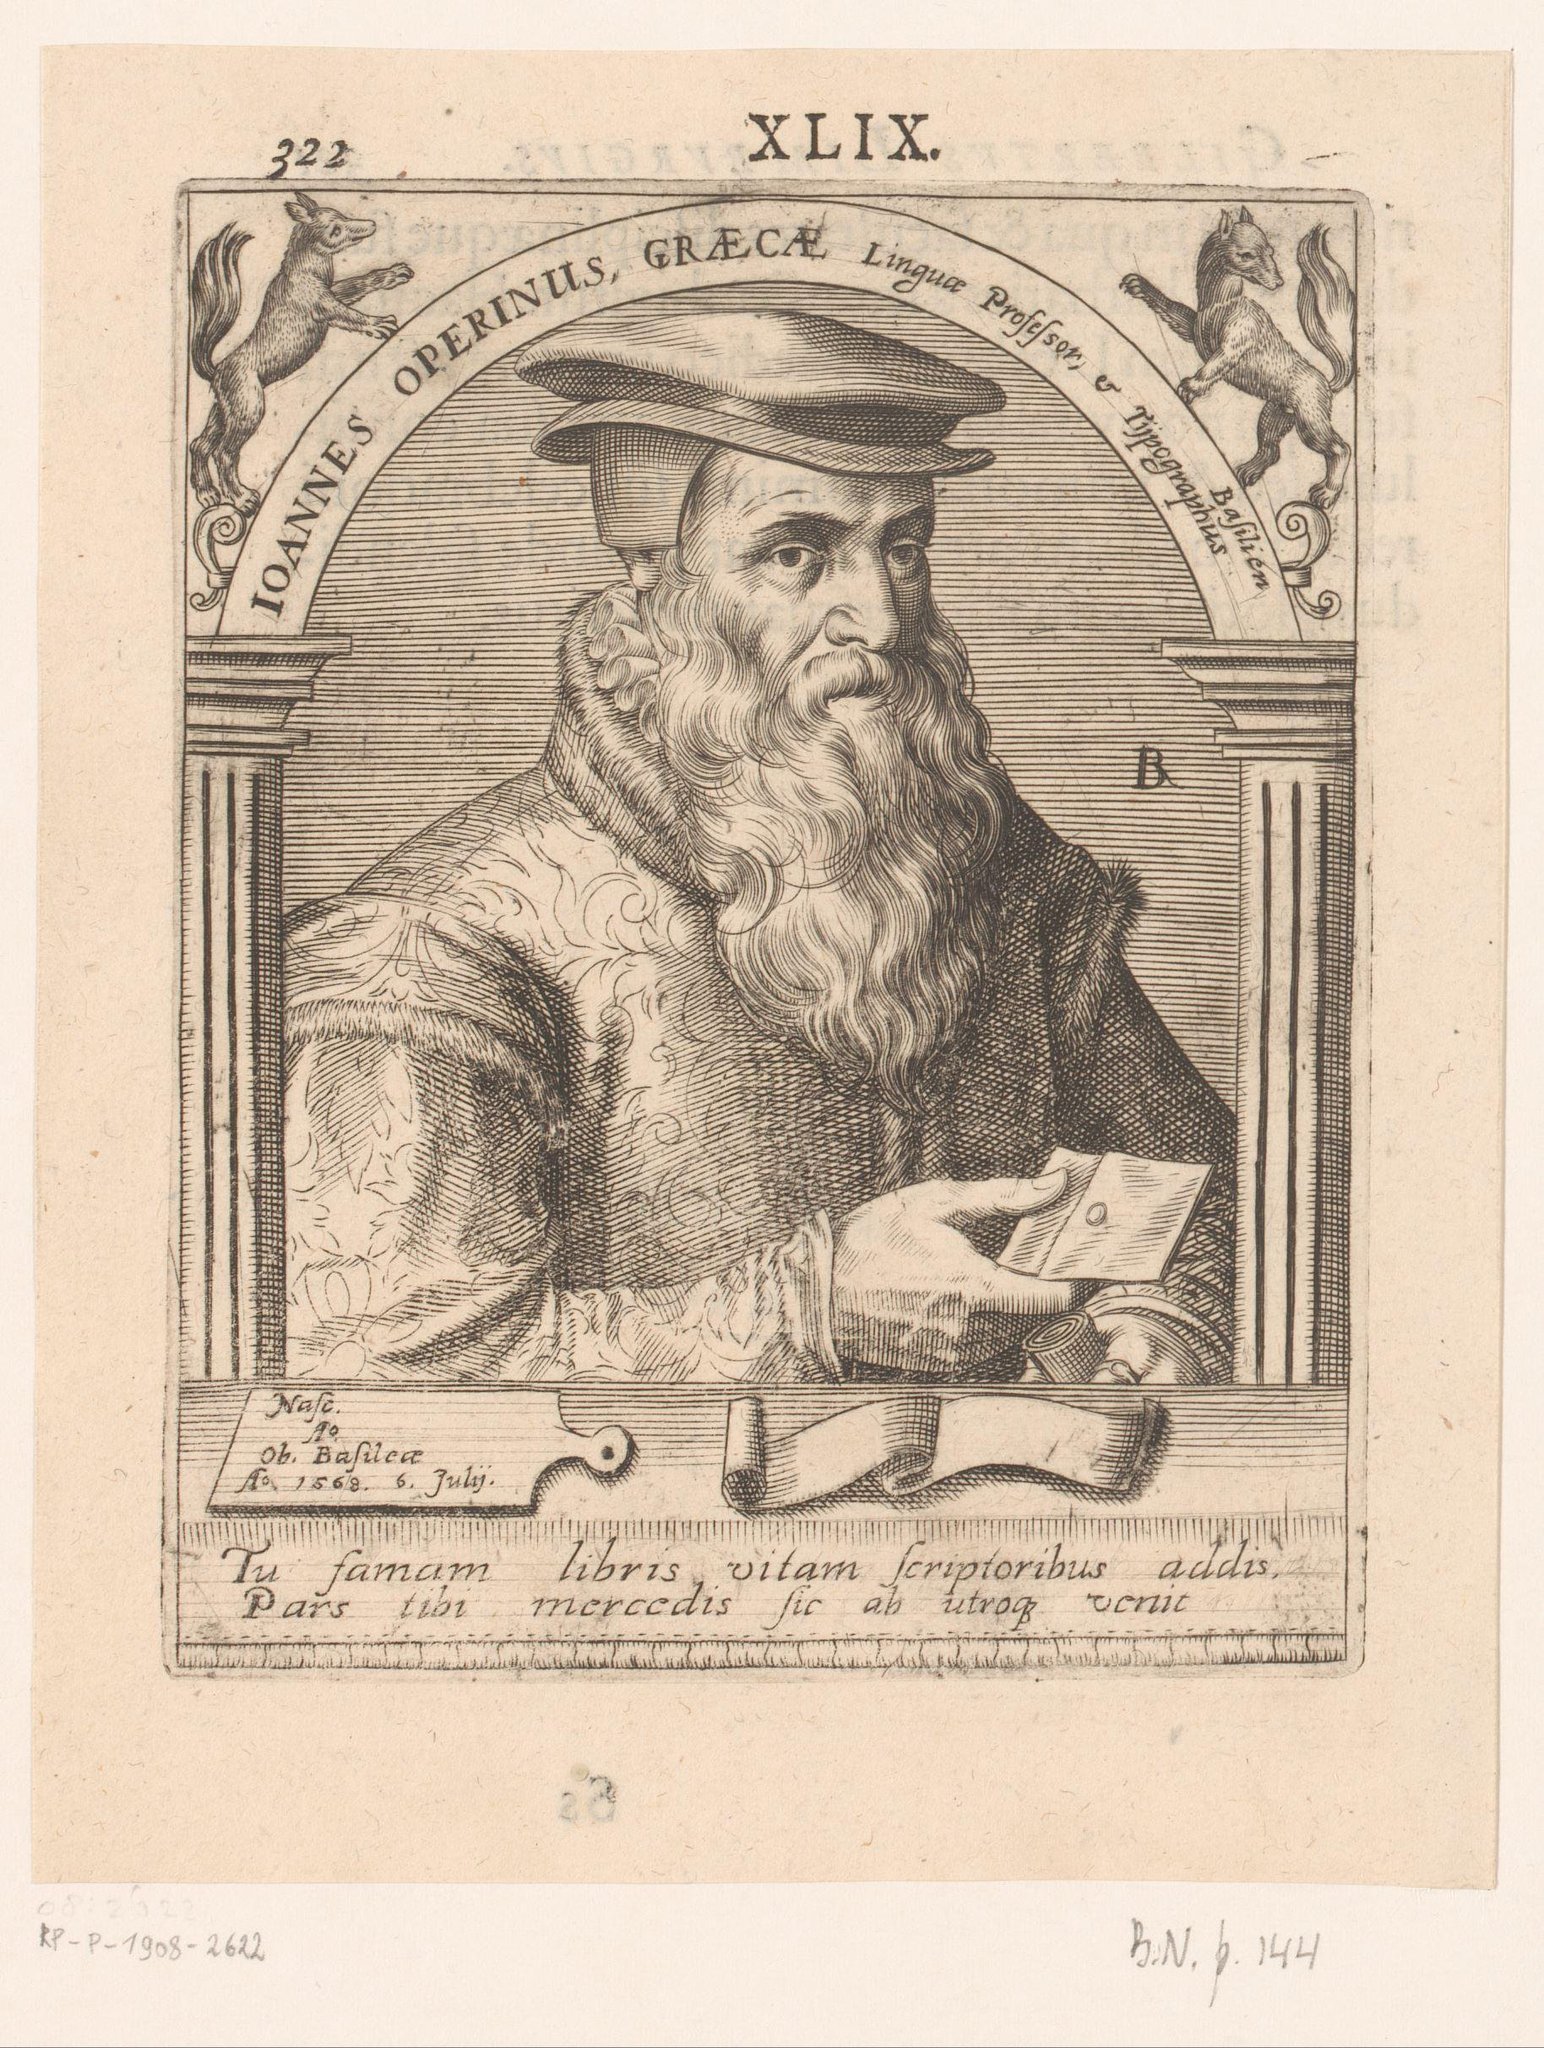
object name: book illustration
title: Joannes Operinus, Graecae Linguae Professor, & Tijpographus Basilien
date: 1597-1599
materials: paper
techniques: engraving, letterpress printing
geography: france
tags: printer, beasts of prey, predatory animals: fox - ff - fabulous animals (sometimes wrongly called 'grotesques'); 'mostri' (ripa), historical persons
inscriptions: collector's mark: Lugt 2228